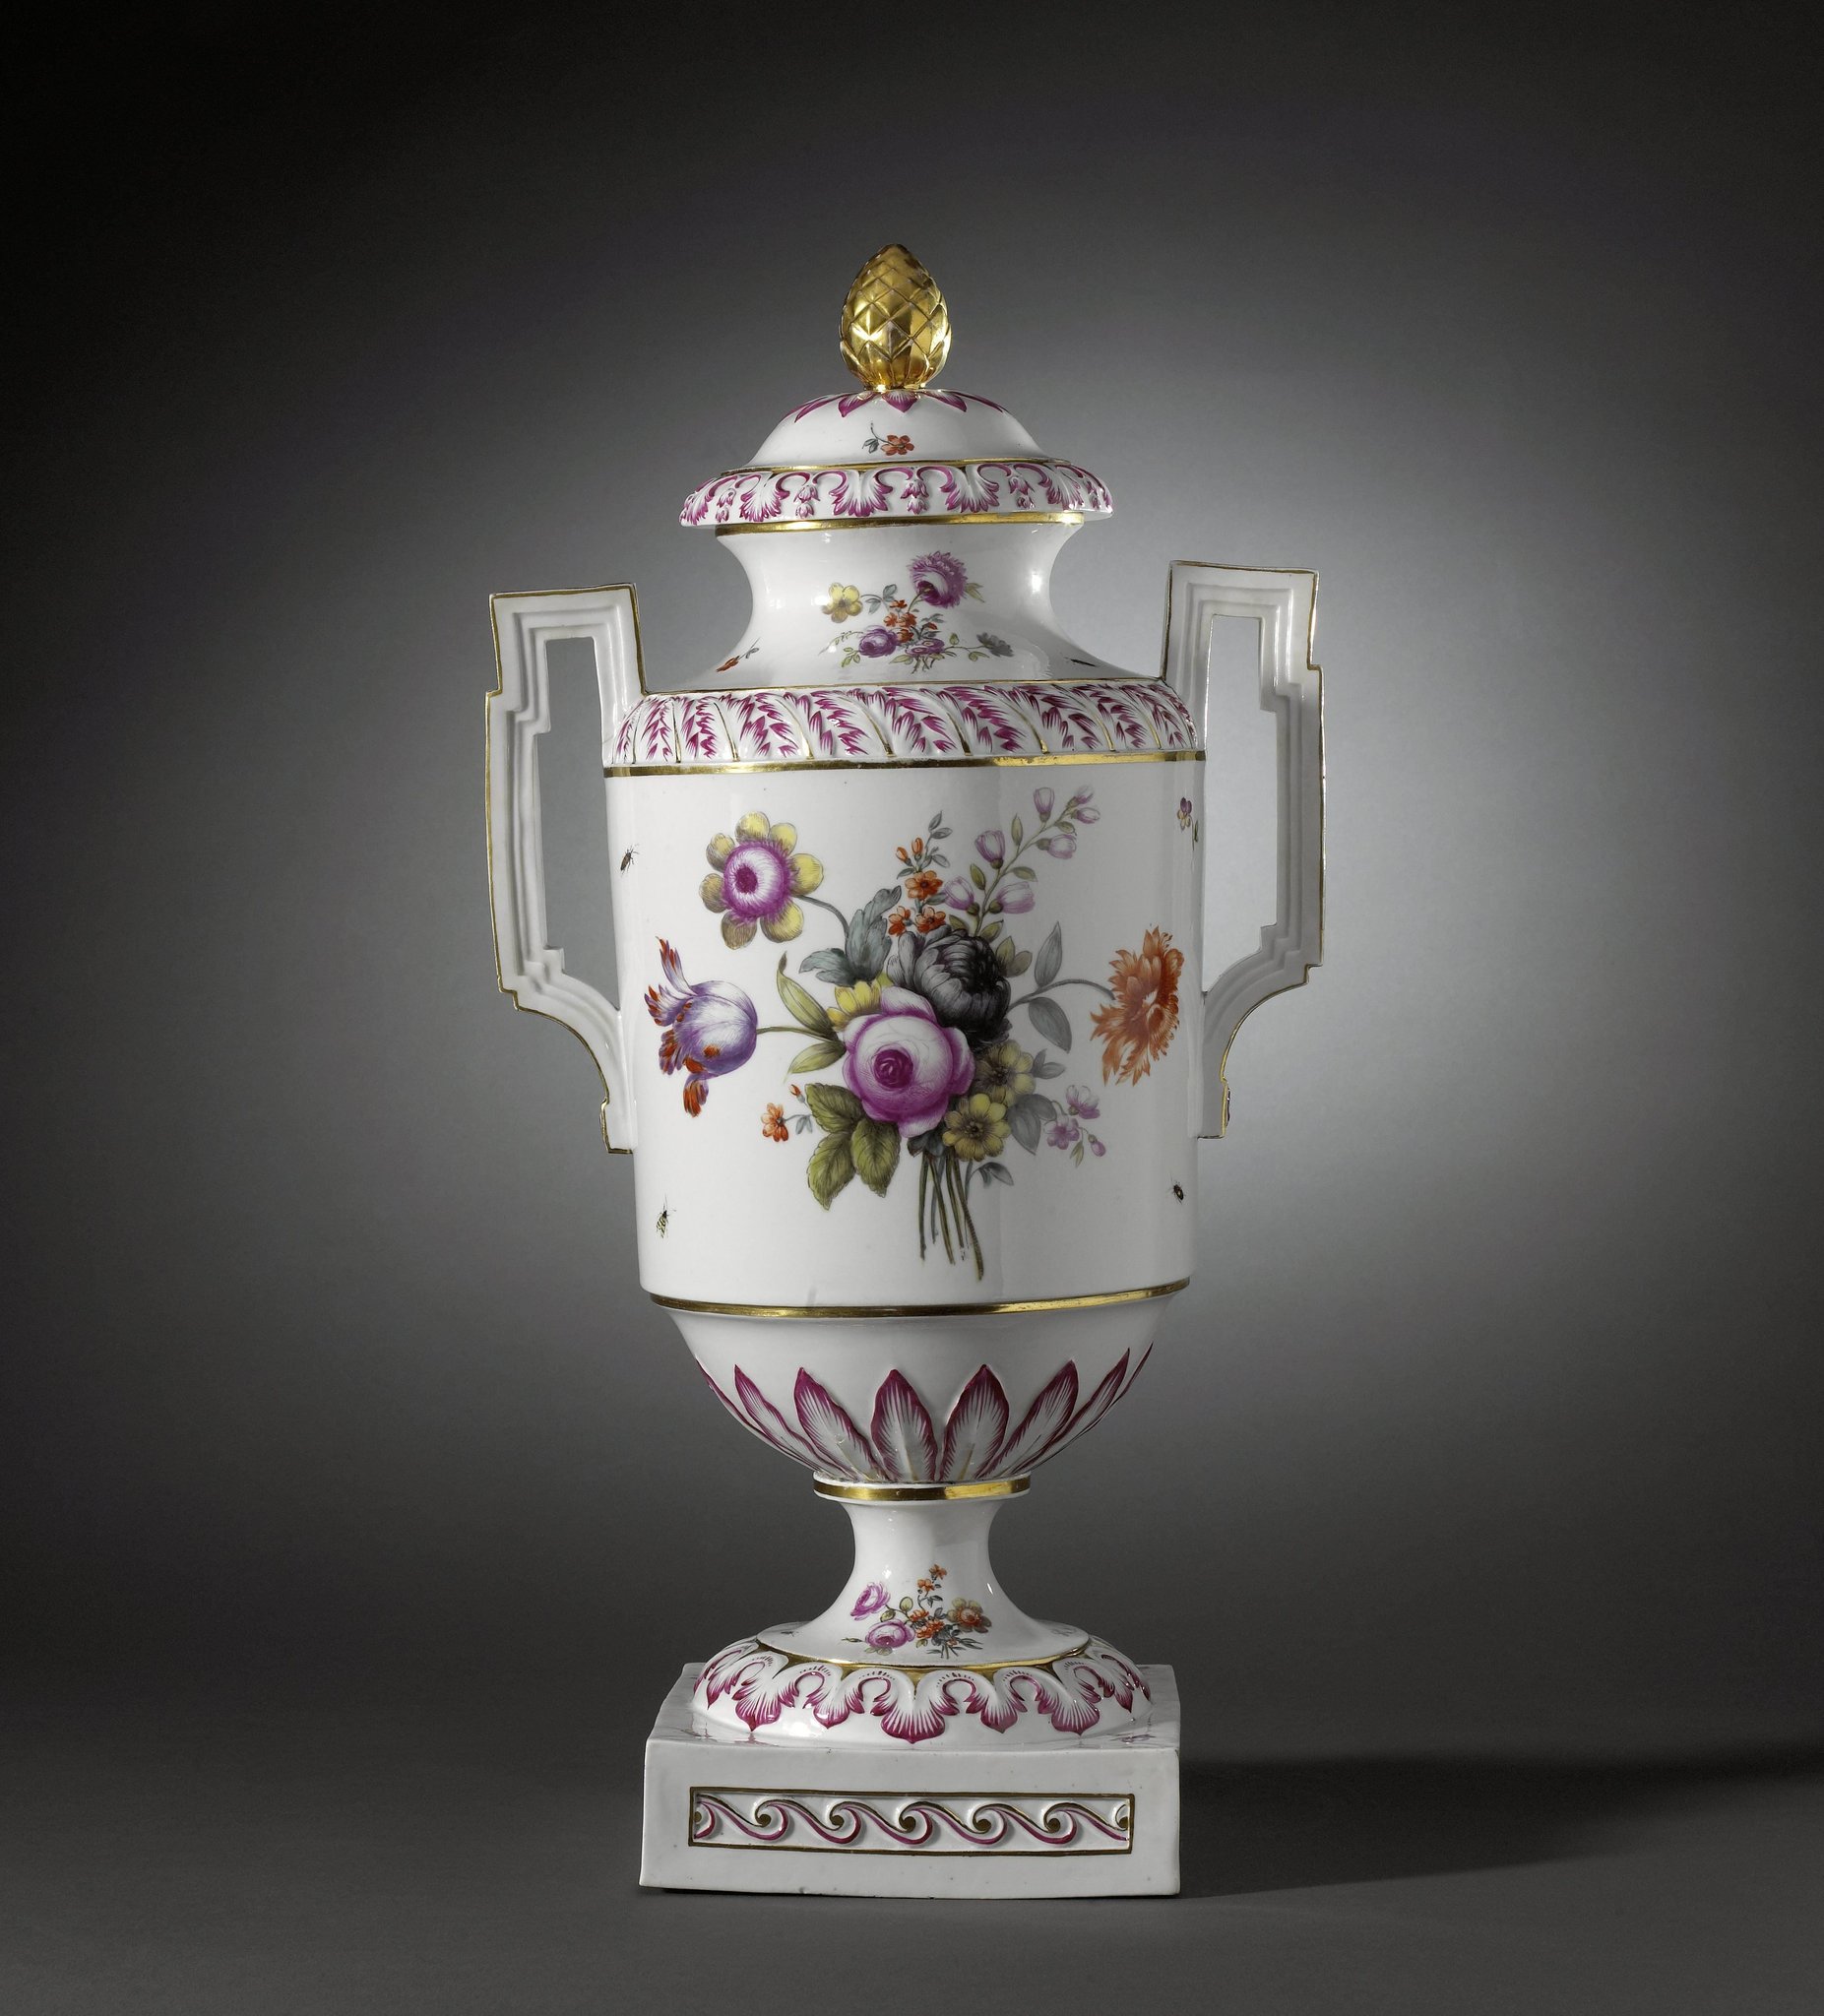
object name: dekselvaas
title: Covered vase with birds on a branch and bouquets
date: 1785-1790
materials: glaze, gold, paint, porcelain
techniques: firing, forming, gilding, relief, turning, vitrification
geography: furstenberg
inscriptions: mark: ‘F/ A.F.’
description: Dekselvaas van porselein op een spreidende voet eindigend in een vierkant voetstuk en met een cilindrisch lichaam met ronde schouder en zich vernauwend naar de voet. Spreidende nek met een platte rand en hoge, hoekige oren. Beschilderd op het glazuur in blauw, rood, roze, groen, geel, paars, zwart en goud. Op de buik twee vogels op een tak in een landschap en een boeket van verschillende bloemen. Hiertussen strooibloemen en insecten. Het vernauwende deel naar de voet met een band met gemodelleerde opstaande bladmotieven in reliëf. De schouder en de voet met dezelfde decoratie als op de buik met daaronder een band met bladranken in reliëf. Op de hoeken van het voetstuk een bloem of insect. De zijkanten met een krulmotief in bas-reliëf. Gouden rand. De deksel met bloemen en insecten en op de rand gemodelleerde bladranken; dekselknop in de vorm van een dennenappel met een gemodelleerde rozet als basis. Gemerkt op de onderzijde met de F en A.F.